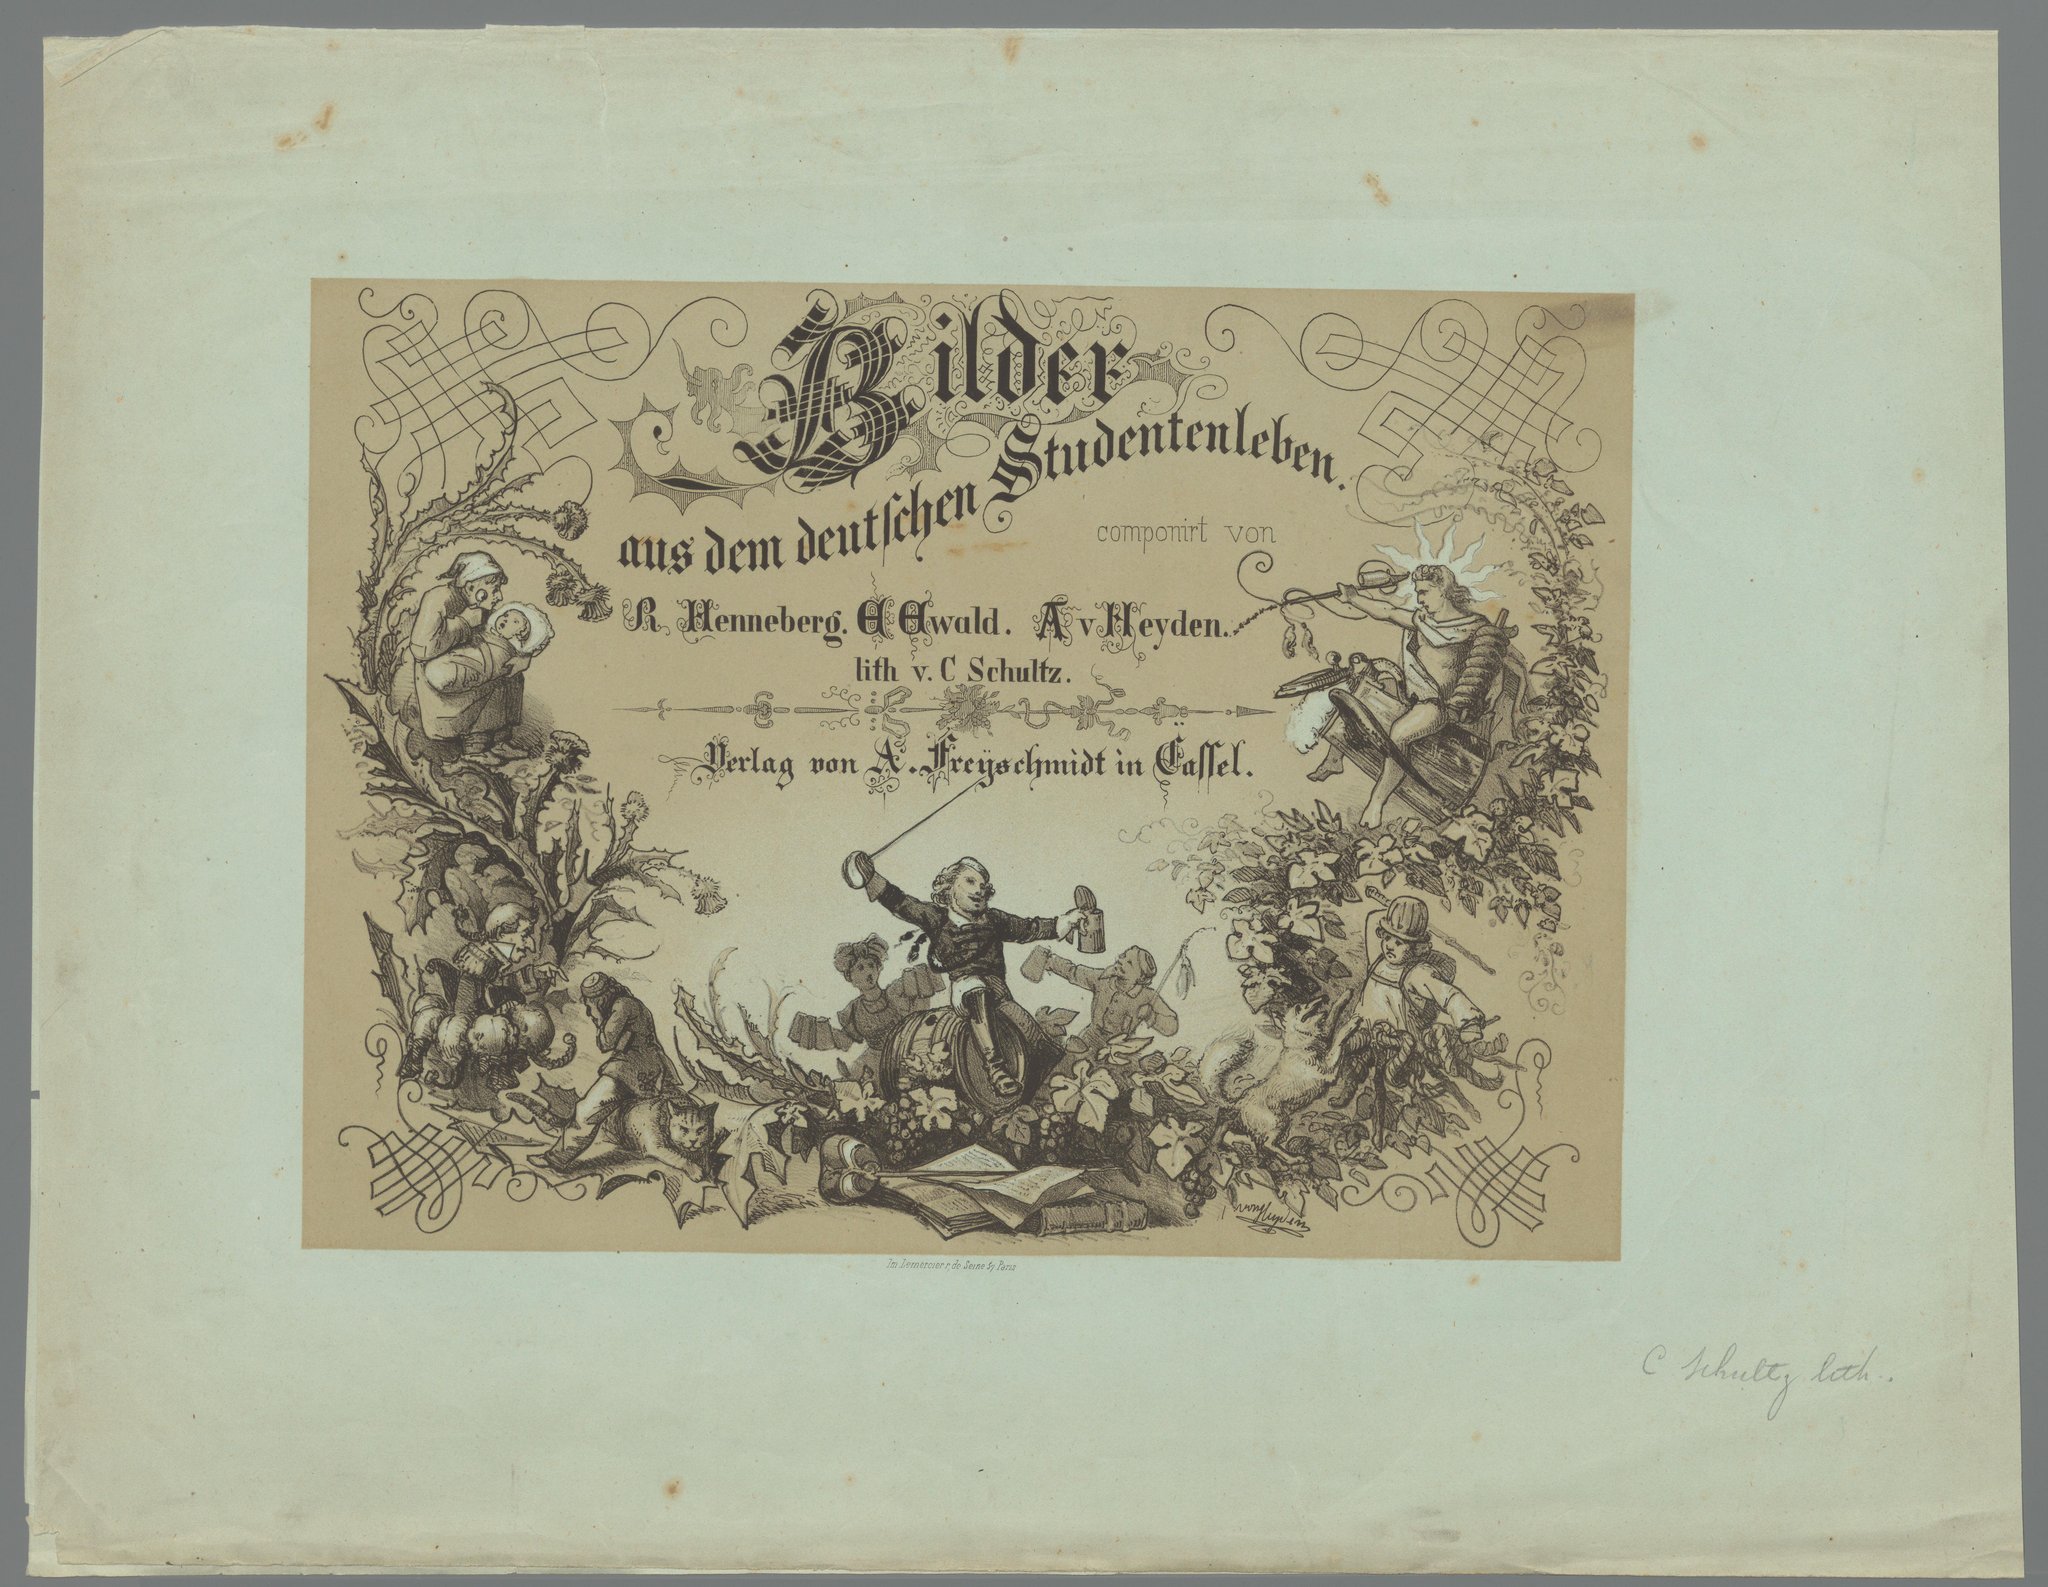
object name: print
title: Bilder aus dem deutschen Studentenleben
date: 1827-1887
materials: paper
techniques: tone lithography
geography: paris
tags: student life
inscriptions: collector's mark: Lugt 2228